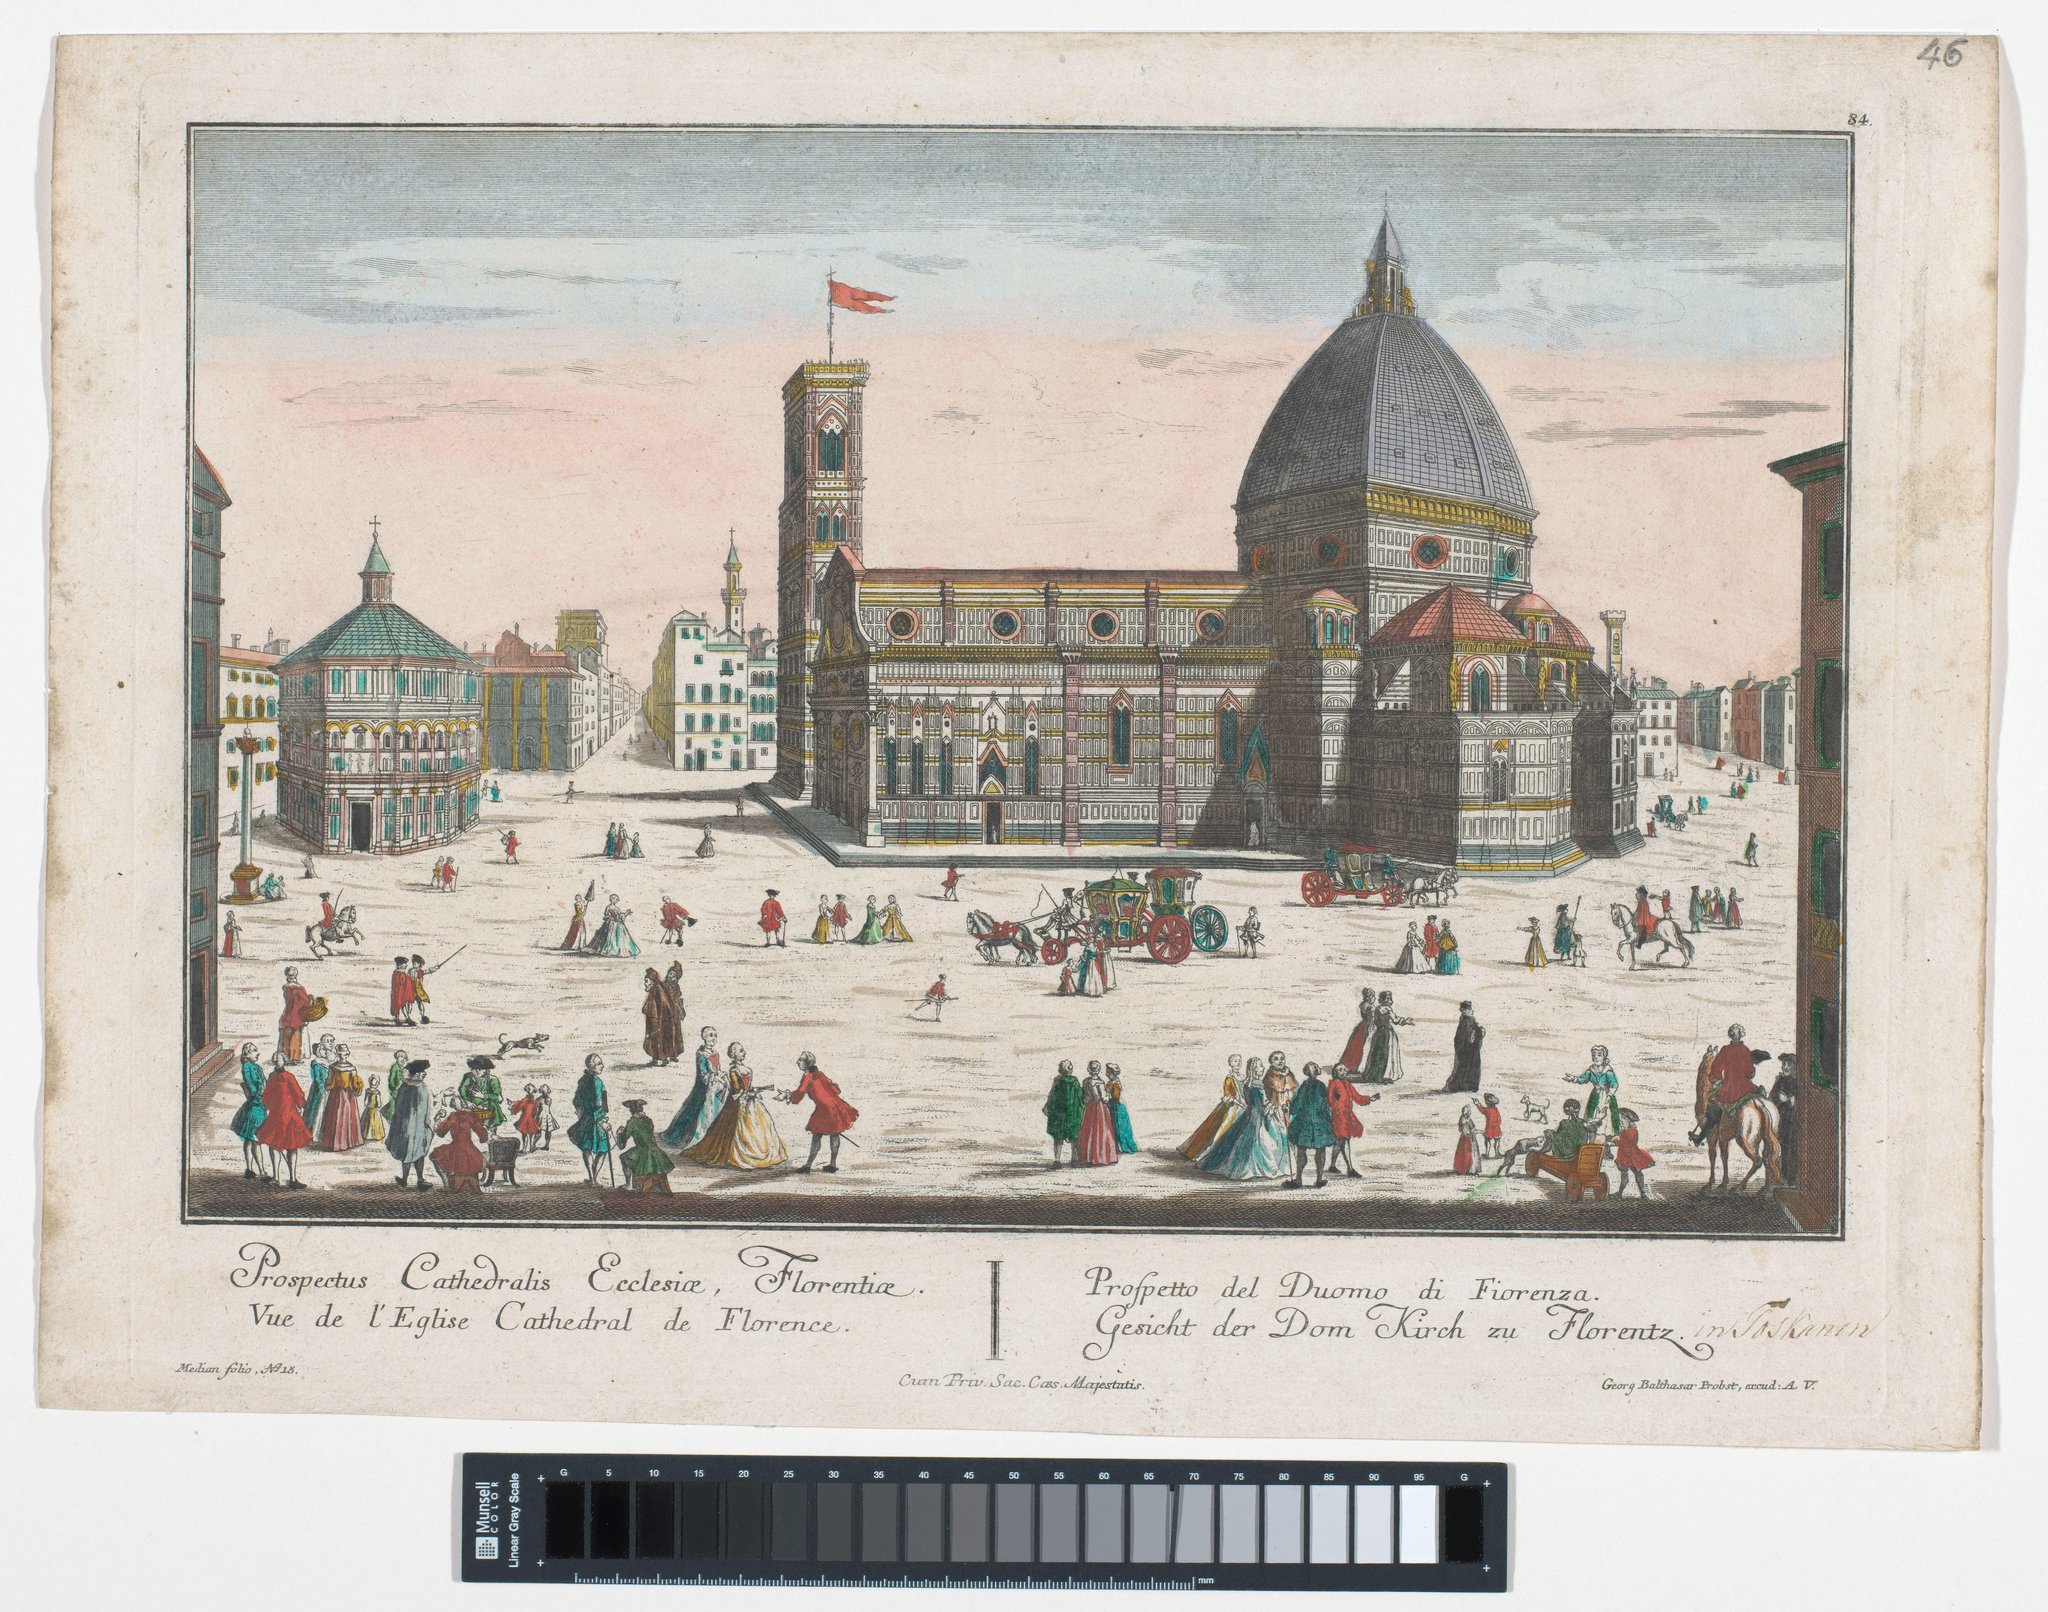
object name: opticaprent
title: Gezicht op de Dom te Florence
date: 1742-1801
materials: paper, watercolor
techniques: brush, etching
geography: germany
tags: tower, clock tower ~ monumental adornment, church (exterior), square, place, circus, etc. (+ city(-scape) with figures, staffage)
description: Links het Baptisterium en in het midden de Campanile. Rechtsboven genummerd: 84. Linksonder genummerd: 15.